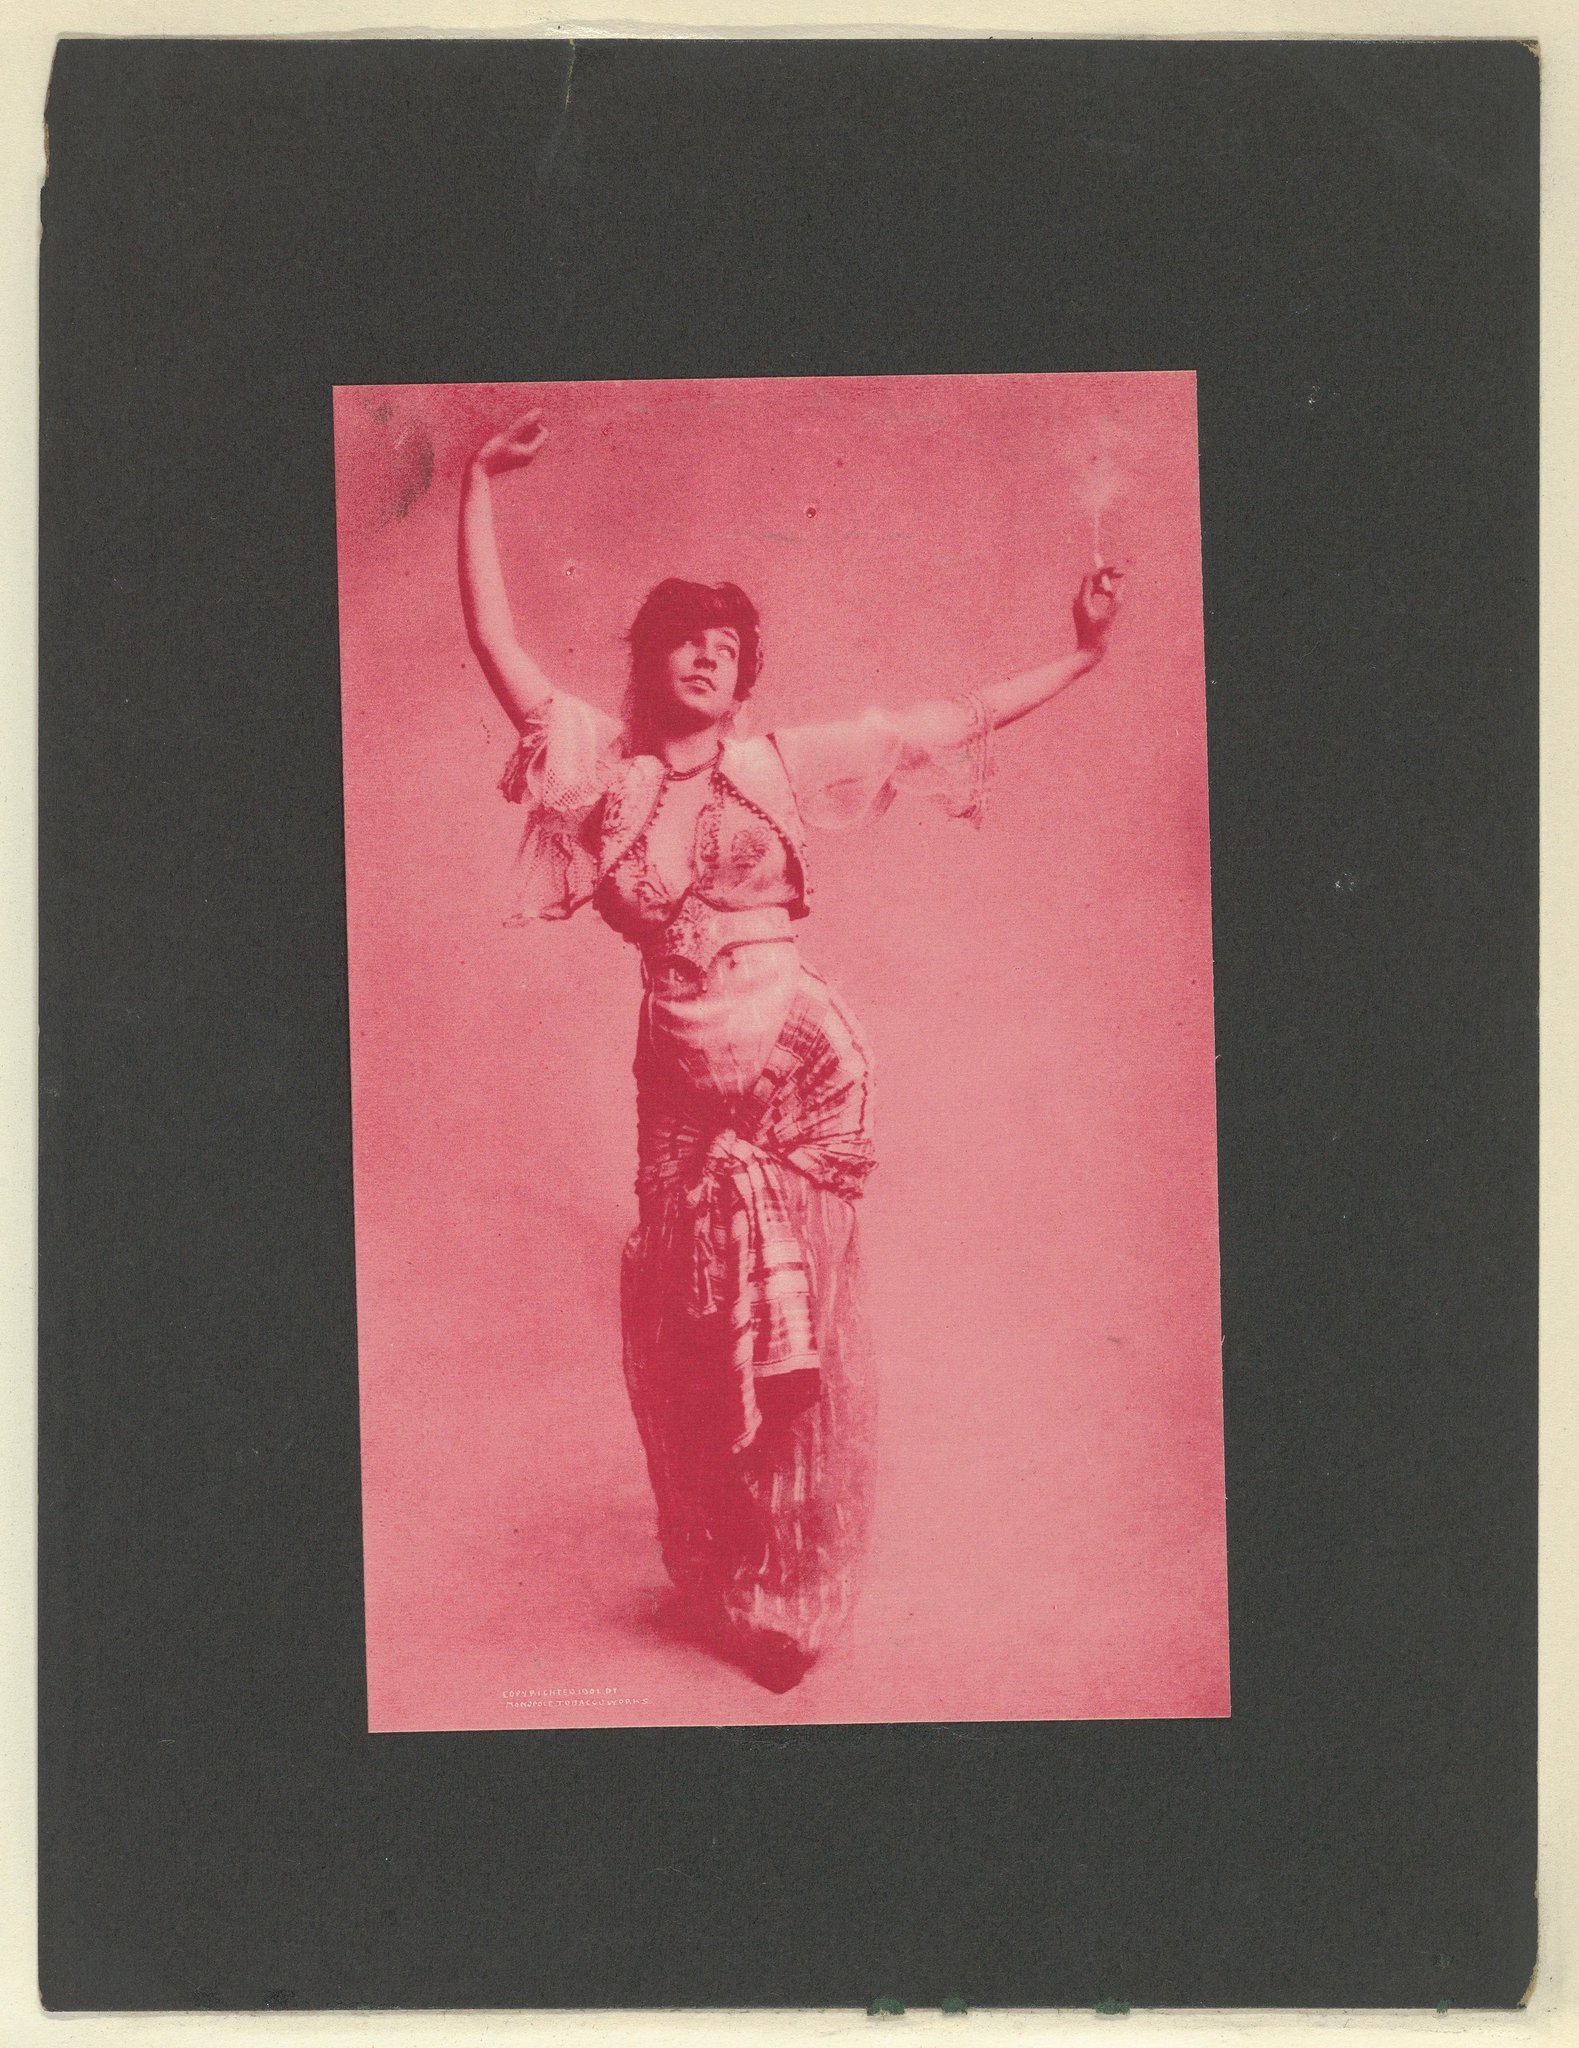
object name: print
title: Plate 6, from Little Egypt Actresses series (T2), issued by Monopole Tobacco Works to promote Khedive Egyptian Cigarettes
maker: monopole tobacco works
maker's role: publisher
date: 1902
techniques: photolithograph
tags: portraits,women,actresses